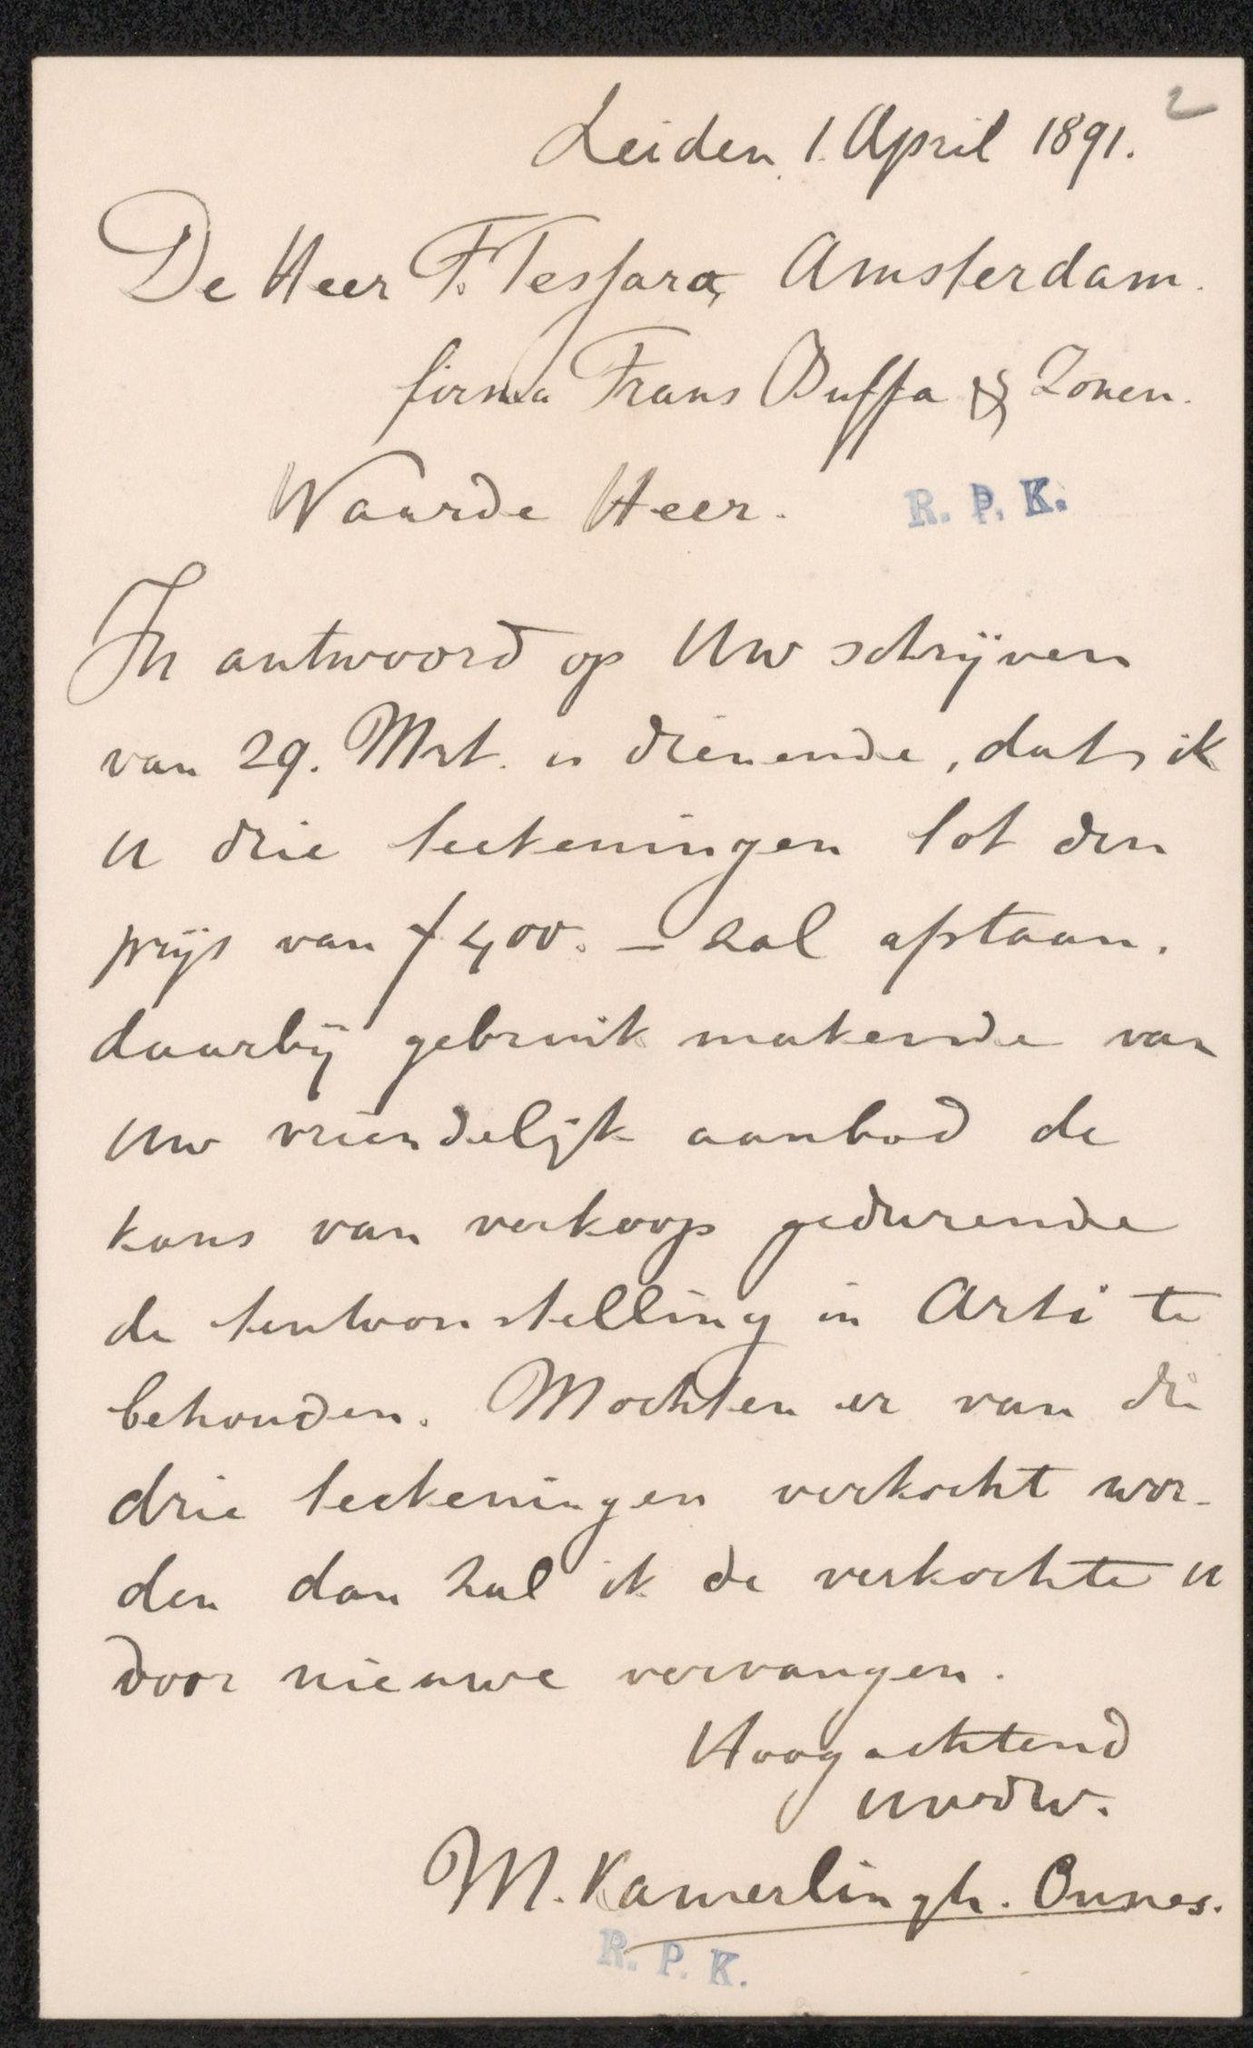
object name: letter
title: Brief aan Filippo Tessaro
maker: menso kamerlingh onnes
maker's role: painter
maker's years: 1860-1925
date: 1891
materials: ink, paper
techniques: pen, writing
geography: leiden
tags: amsterdam, publisher, art trade, art shop, drawing, exhibition ~ art, money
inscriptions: collector's mark: Lugt 2233